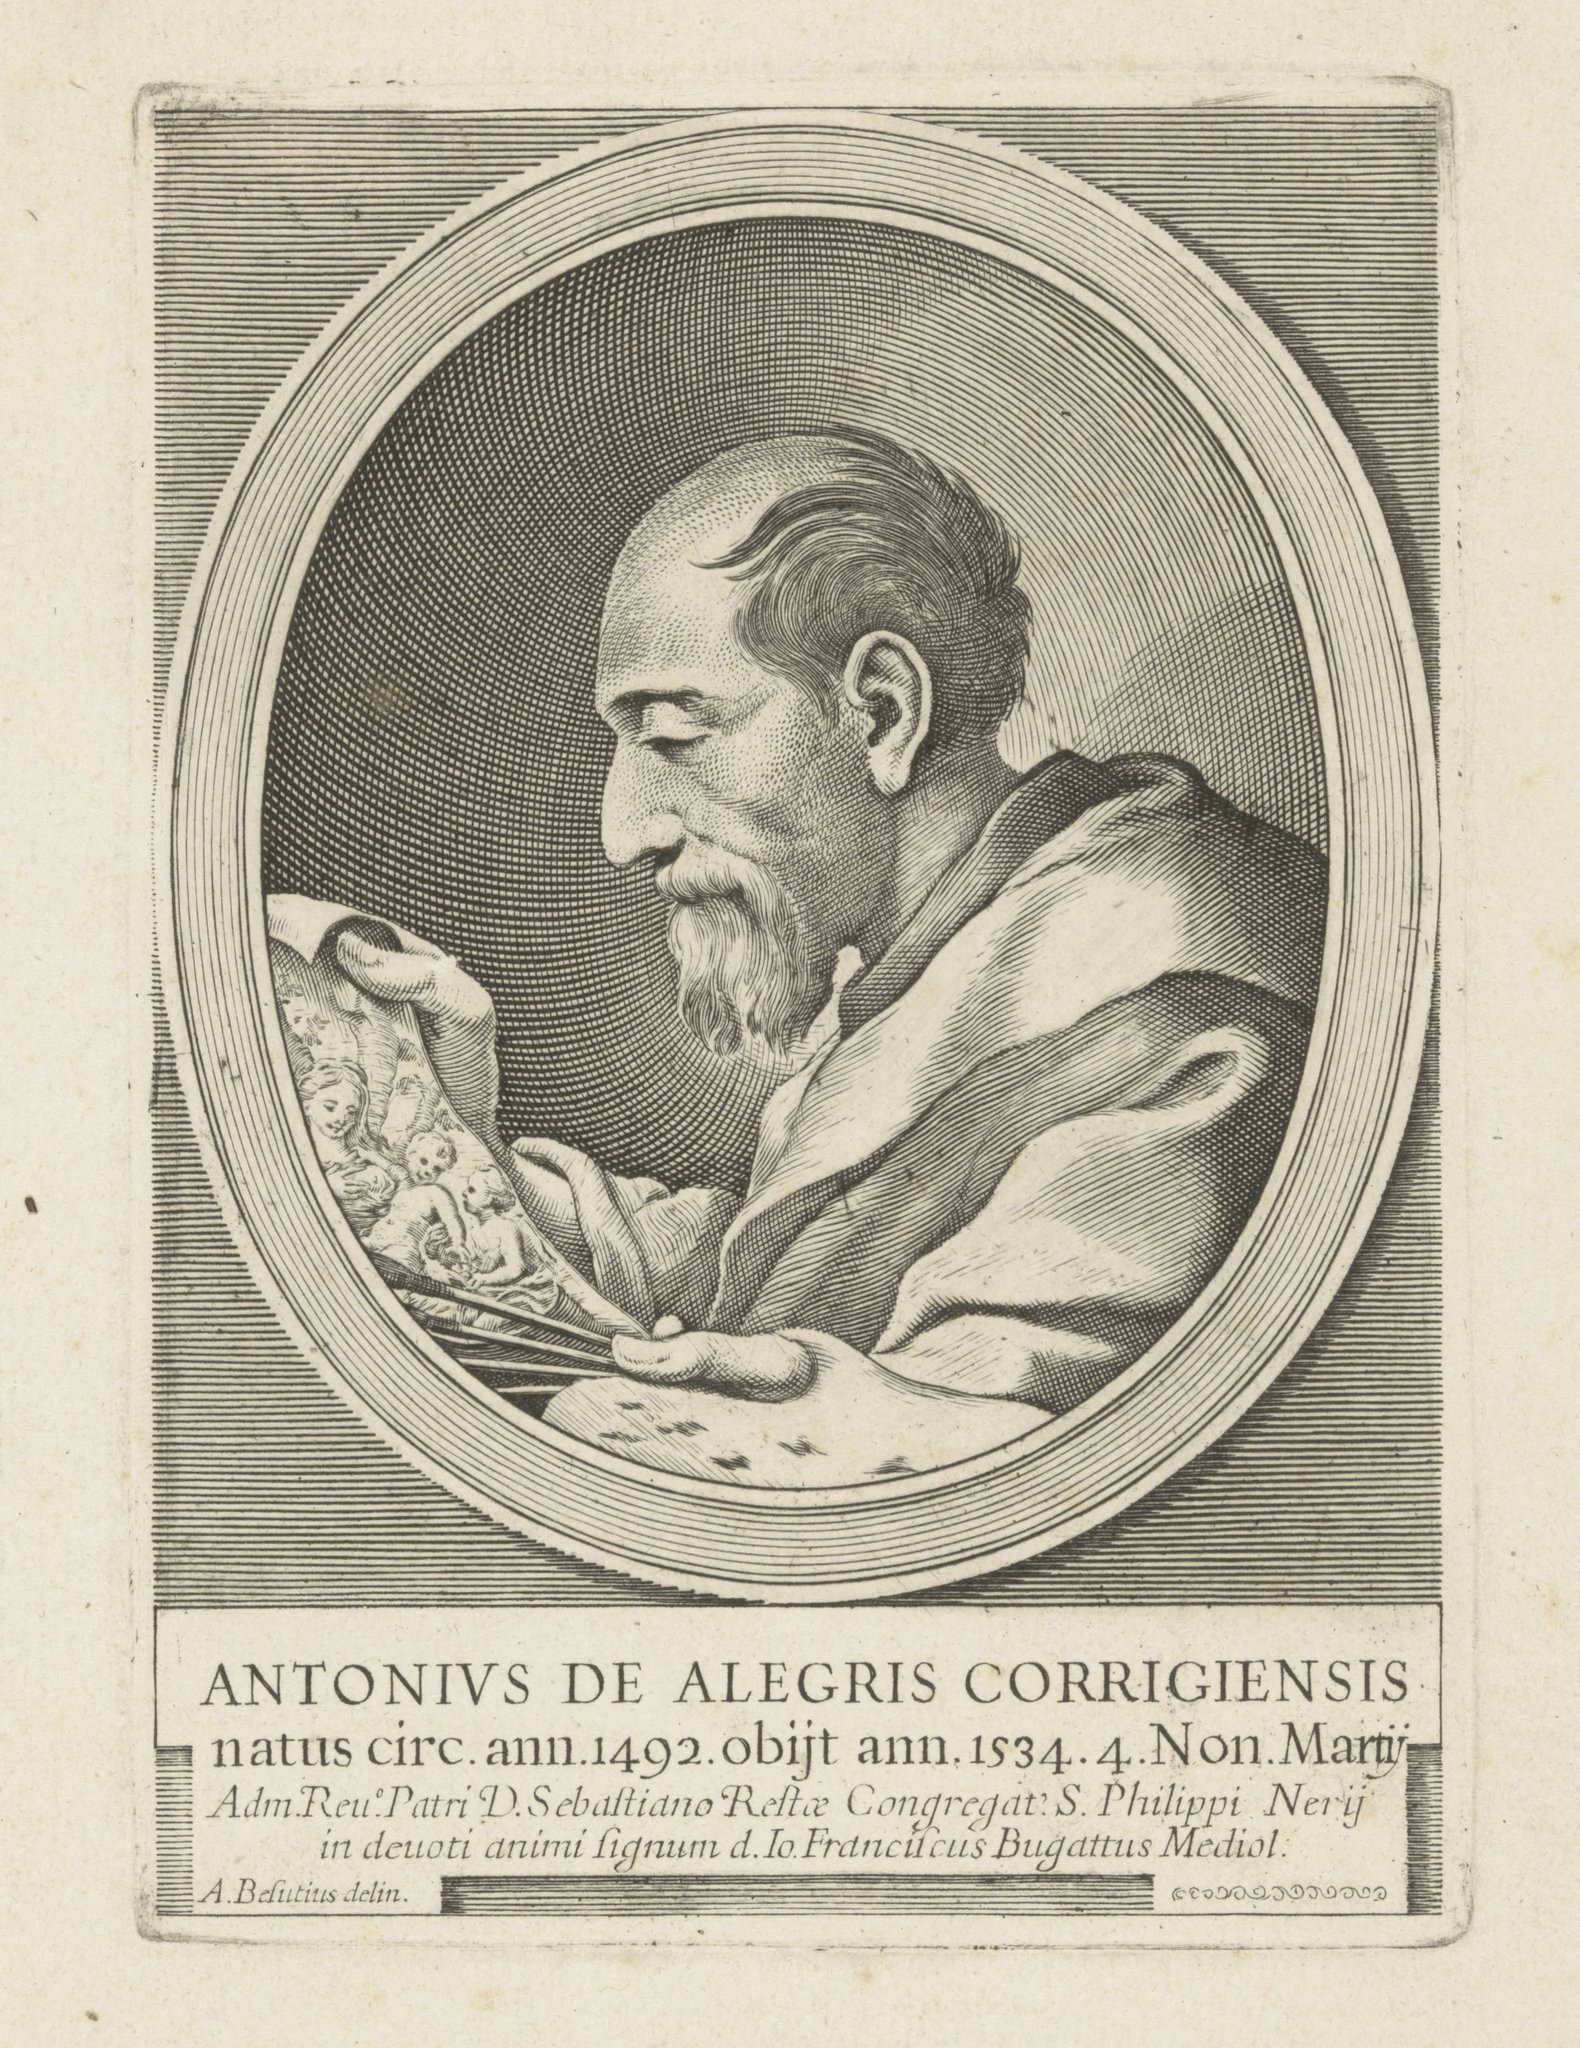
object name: print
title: Portret van de schilder Correggio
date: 1600-1699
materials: paper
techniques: engraving, etching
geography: italy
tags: painter, print maker, draughtsman, correggio, historical persons, portrait, self-portrait of artist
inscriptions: collector's mark: Lugt 240